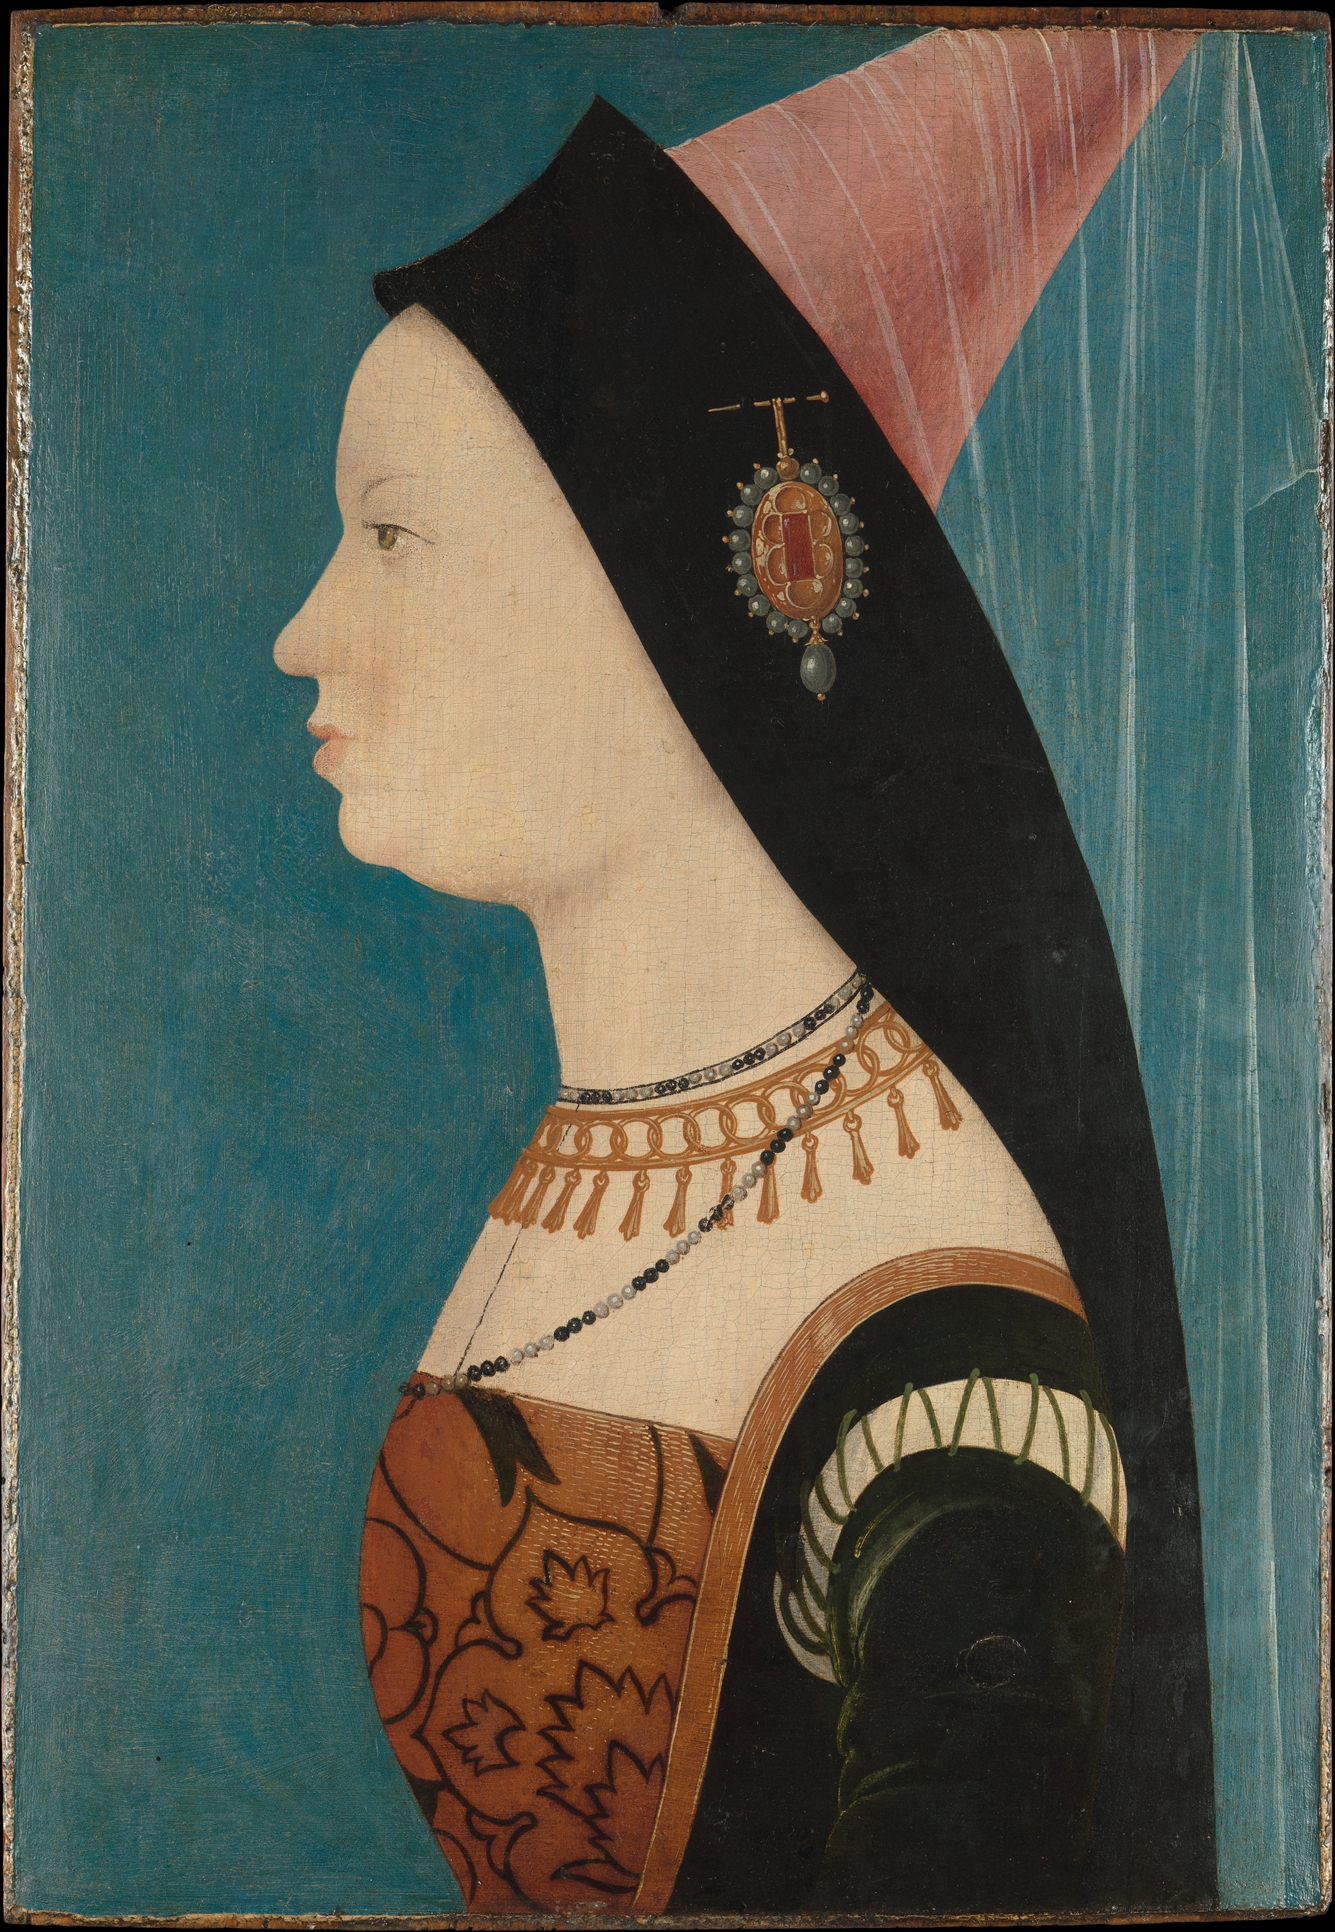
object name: painting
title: Mary of Burgundy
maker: master h.a. or a.h.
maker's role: artist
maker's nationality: austrian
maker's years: 1520-1530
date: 1528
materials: oil, panel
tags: portraits,profiles,women